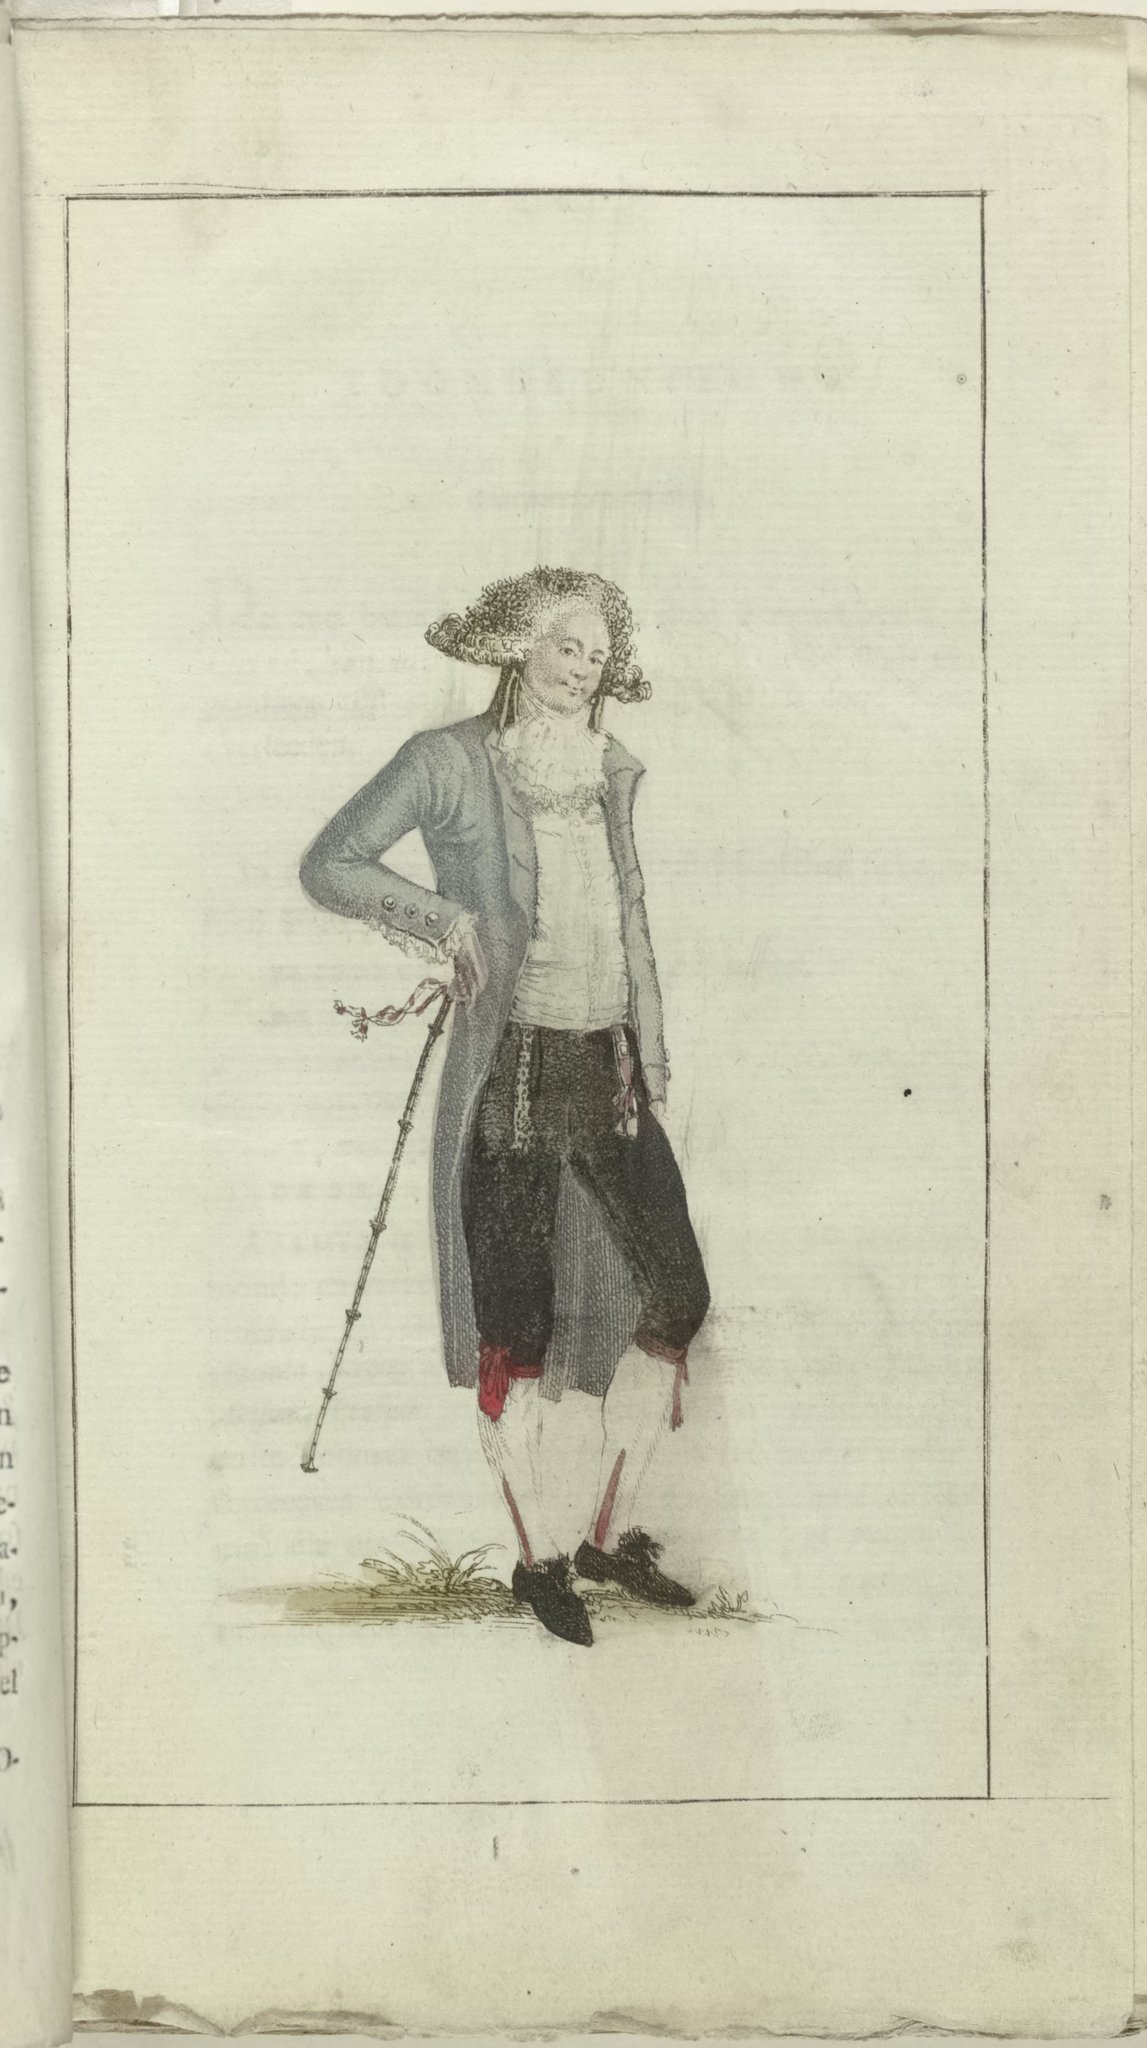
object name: fashion print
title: Kabinet van mode en smaak 1791, pl. I: Petit Maitre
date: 1791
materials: paper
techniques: etching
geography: haarlem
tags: fashion plates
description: Een elegant geklede 'Petit Maitre' in lichtblauwe frak... (p.42), met wandelstok